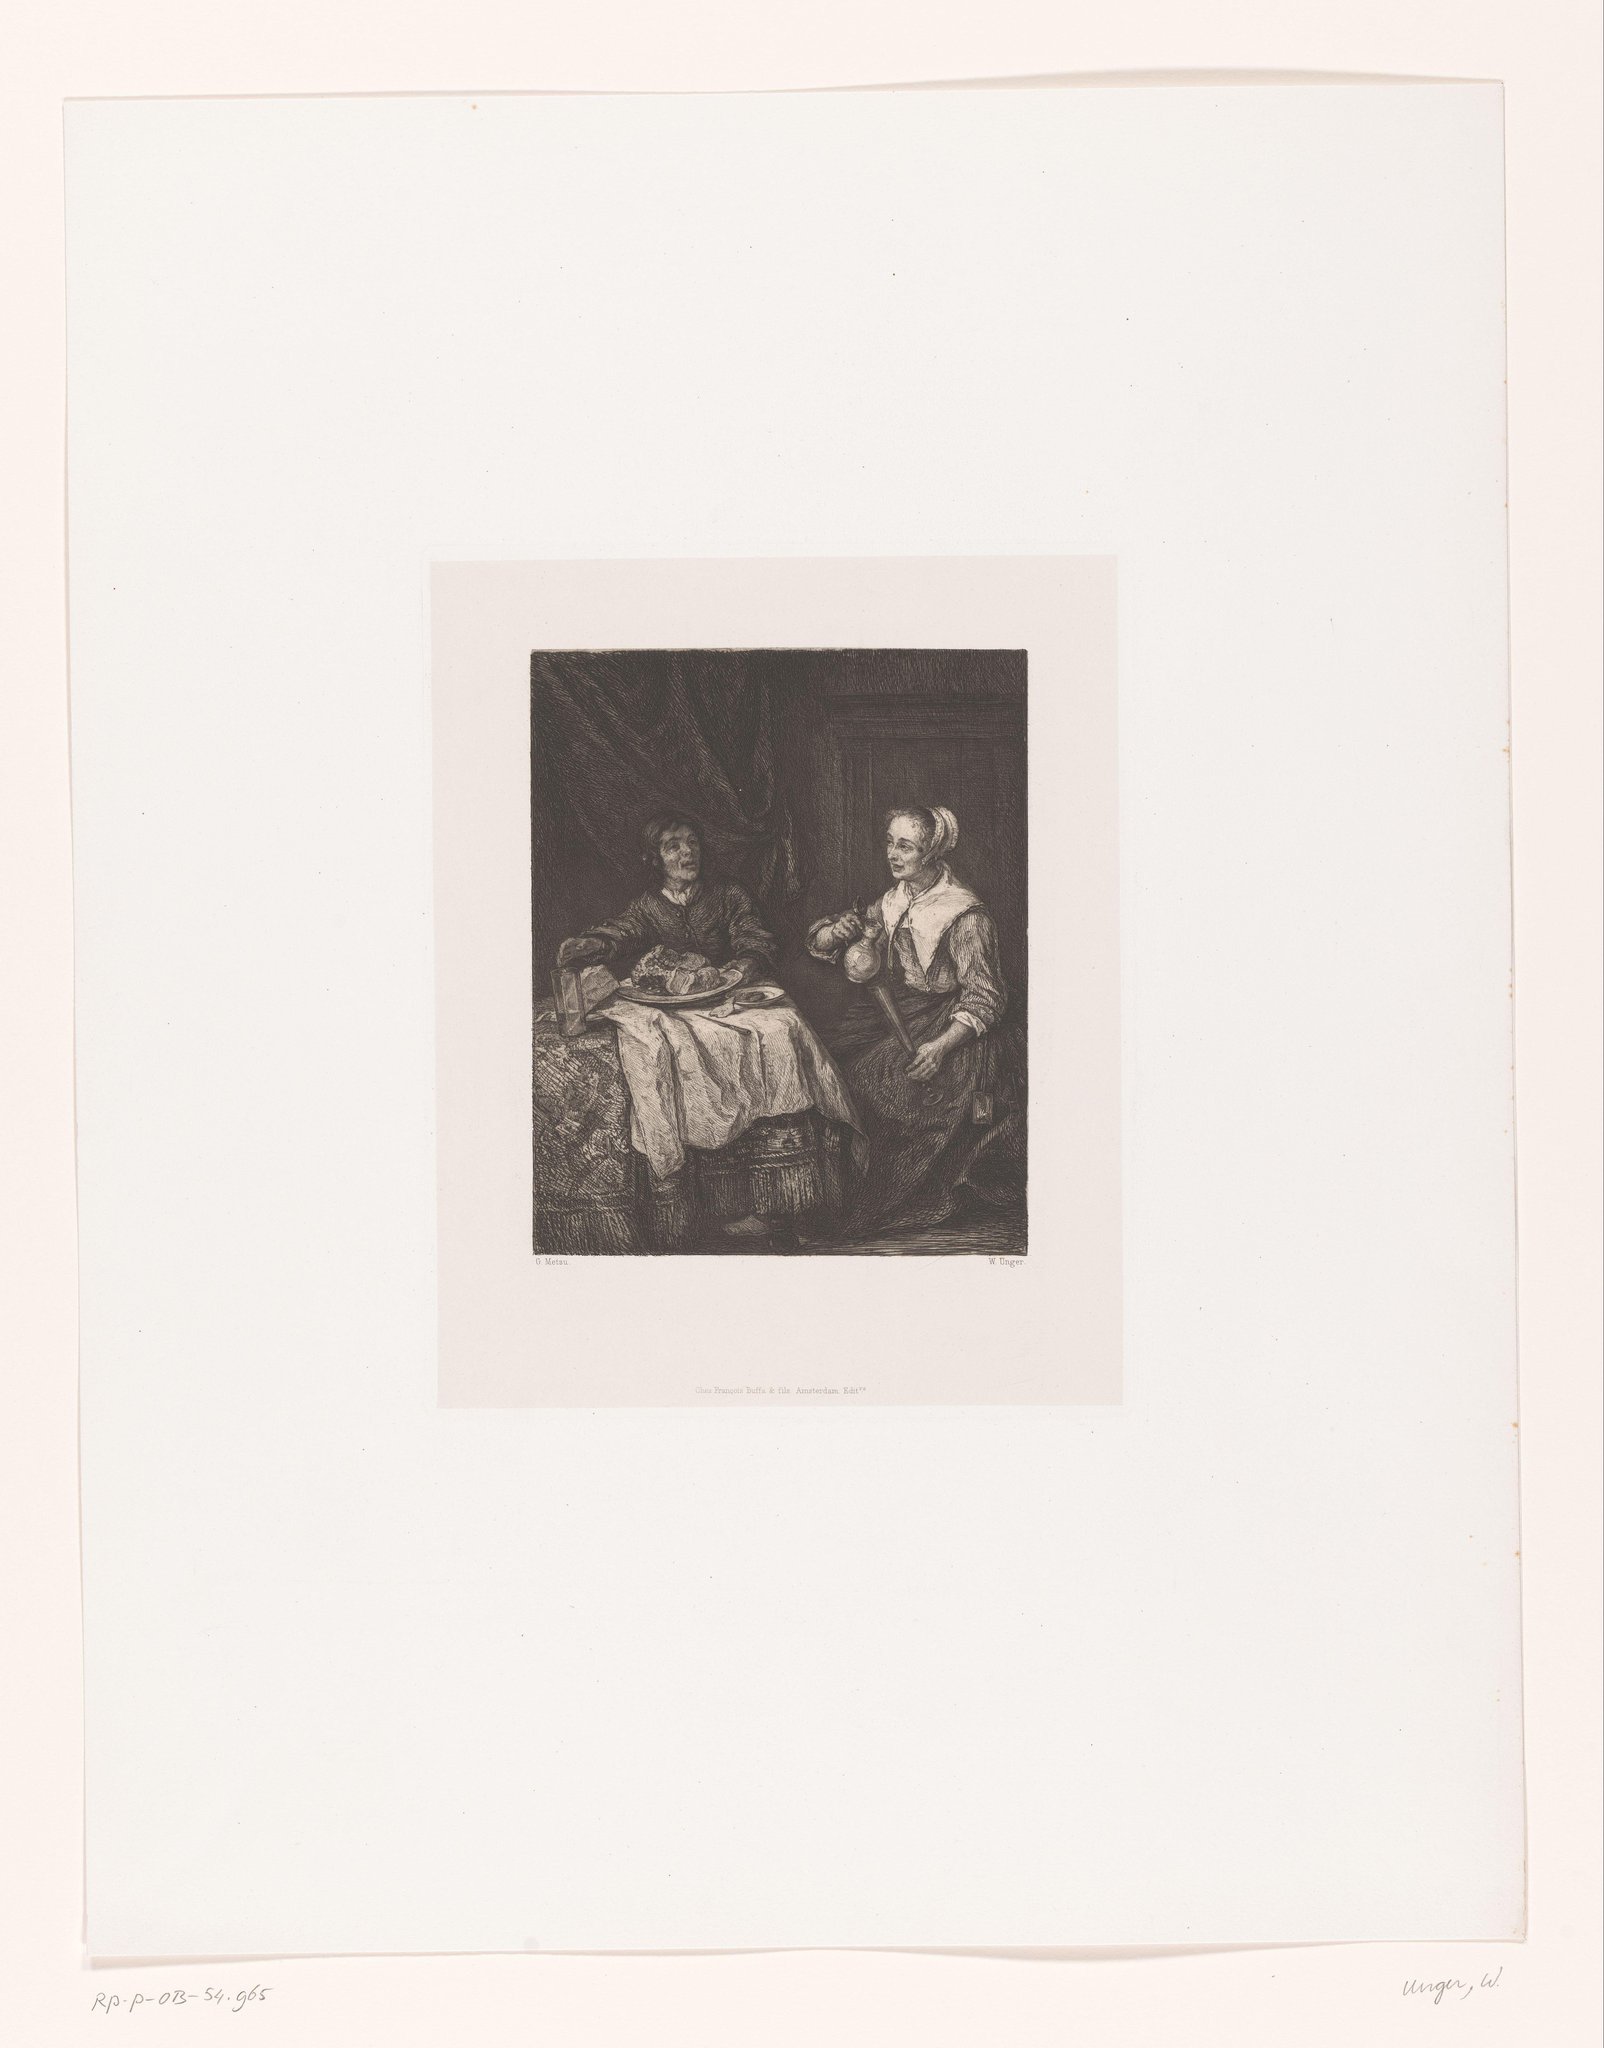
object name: print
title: Man en vrouw aan de maaltijd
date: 1847-1889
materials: paper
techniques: etching, intaglio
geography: germany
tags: pouring, bread, loaf, laid table: table-ware, table-decoration, etc.